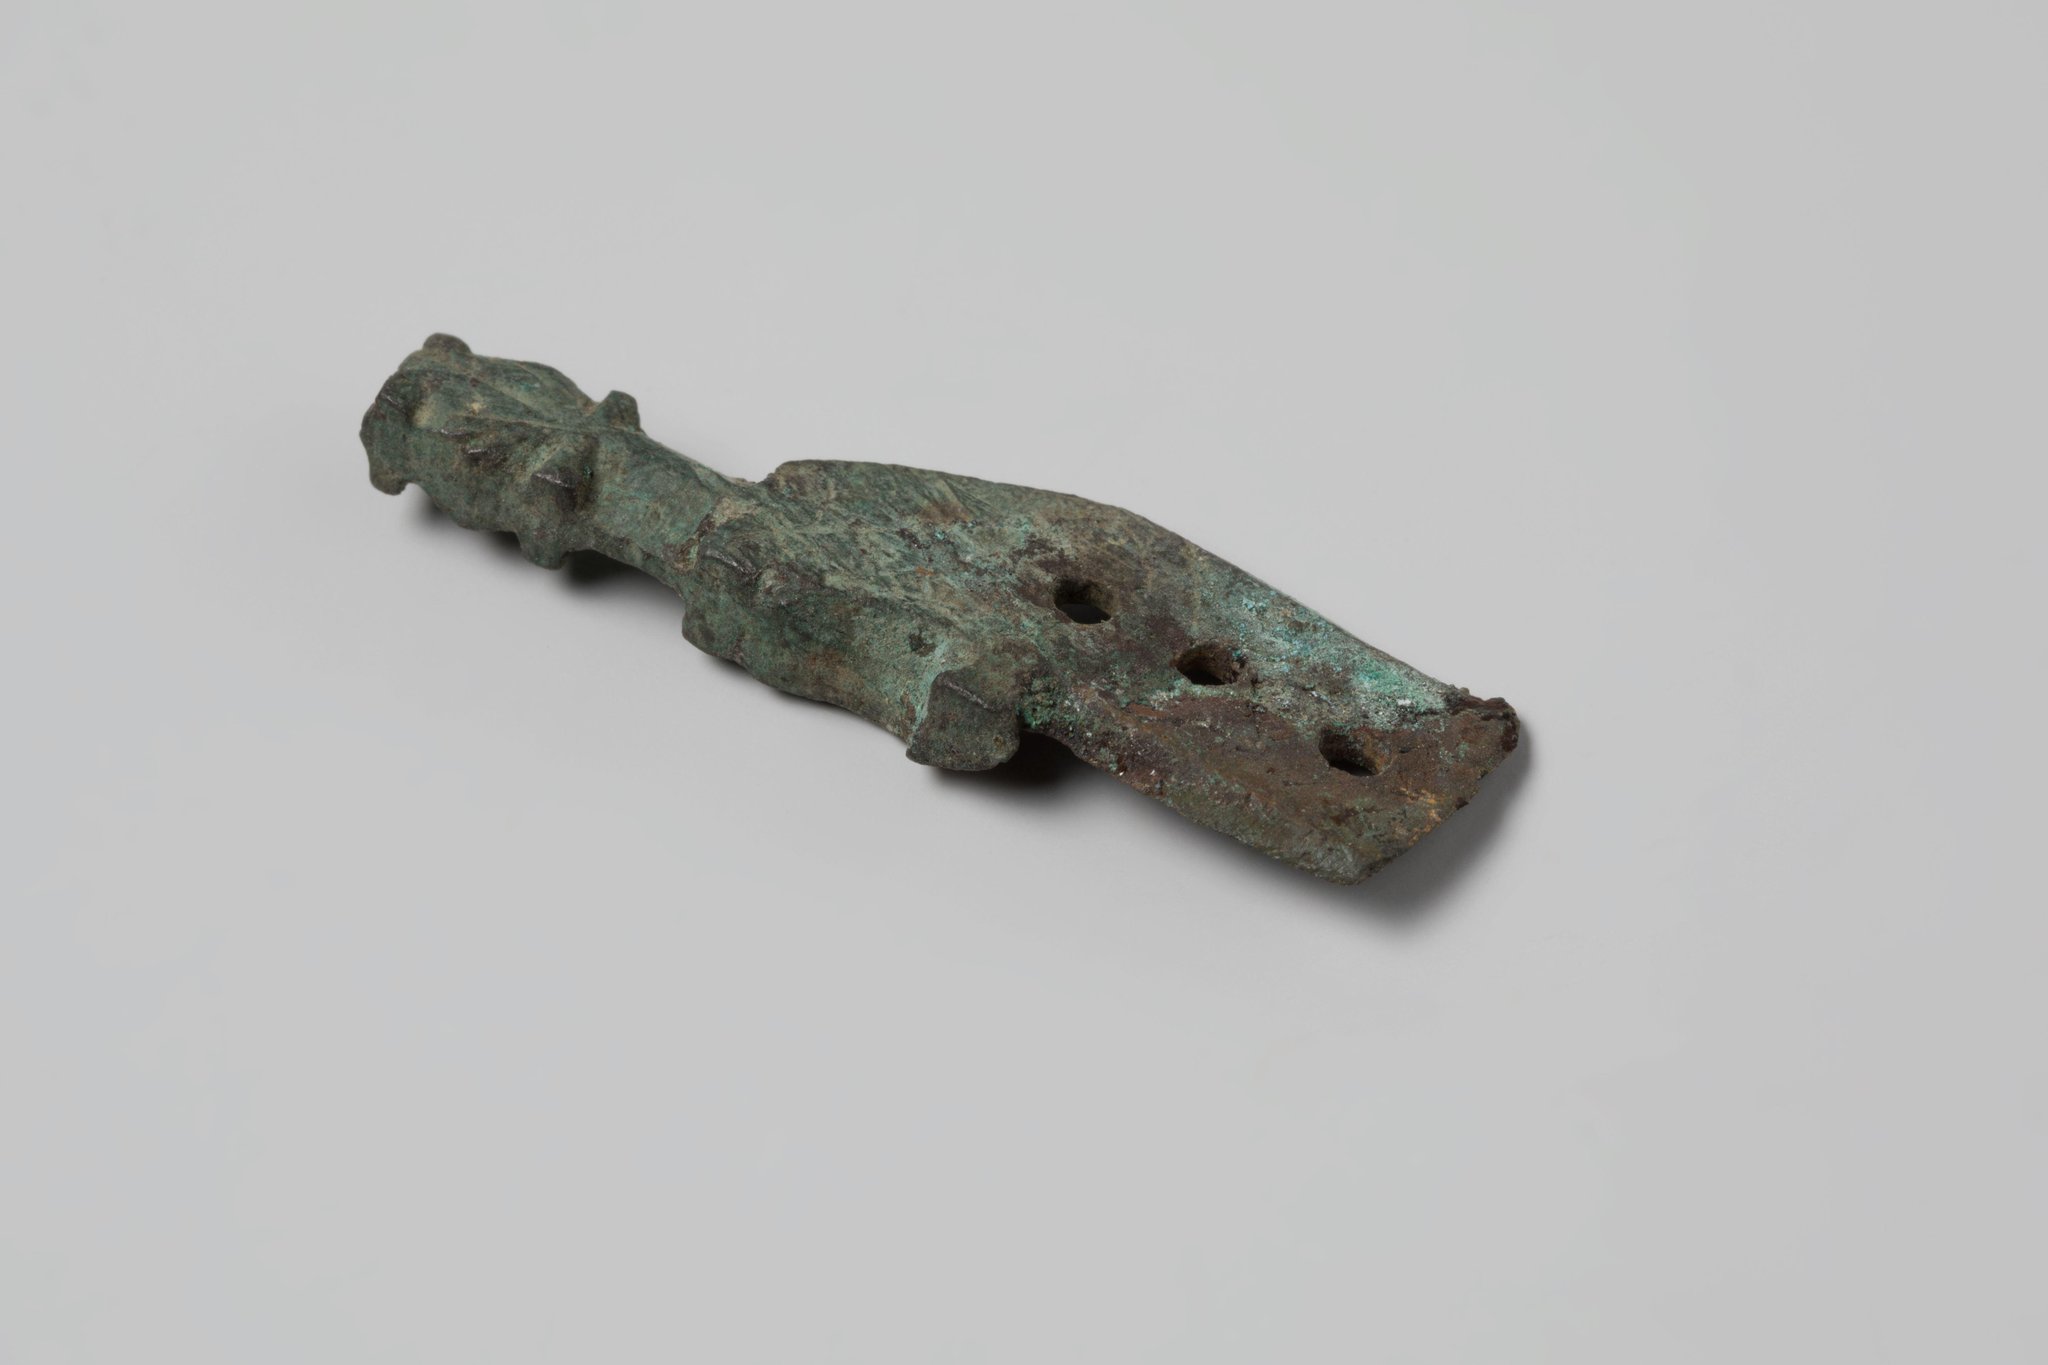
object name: pin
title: Fragment speld uit het wrak van de Oost-Indiëvaarder Hollandia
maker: Anonymous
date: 1700-1743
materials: copper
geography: netherlands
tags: verenigde oostindische compagnie, hollandia (schip), annet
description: Tools and instruments, sewing and sailmaking, pin; fragm of shaft with blade-mount, 3 rivet-holes, id. NG 1980-27H3265.